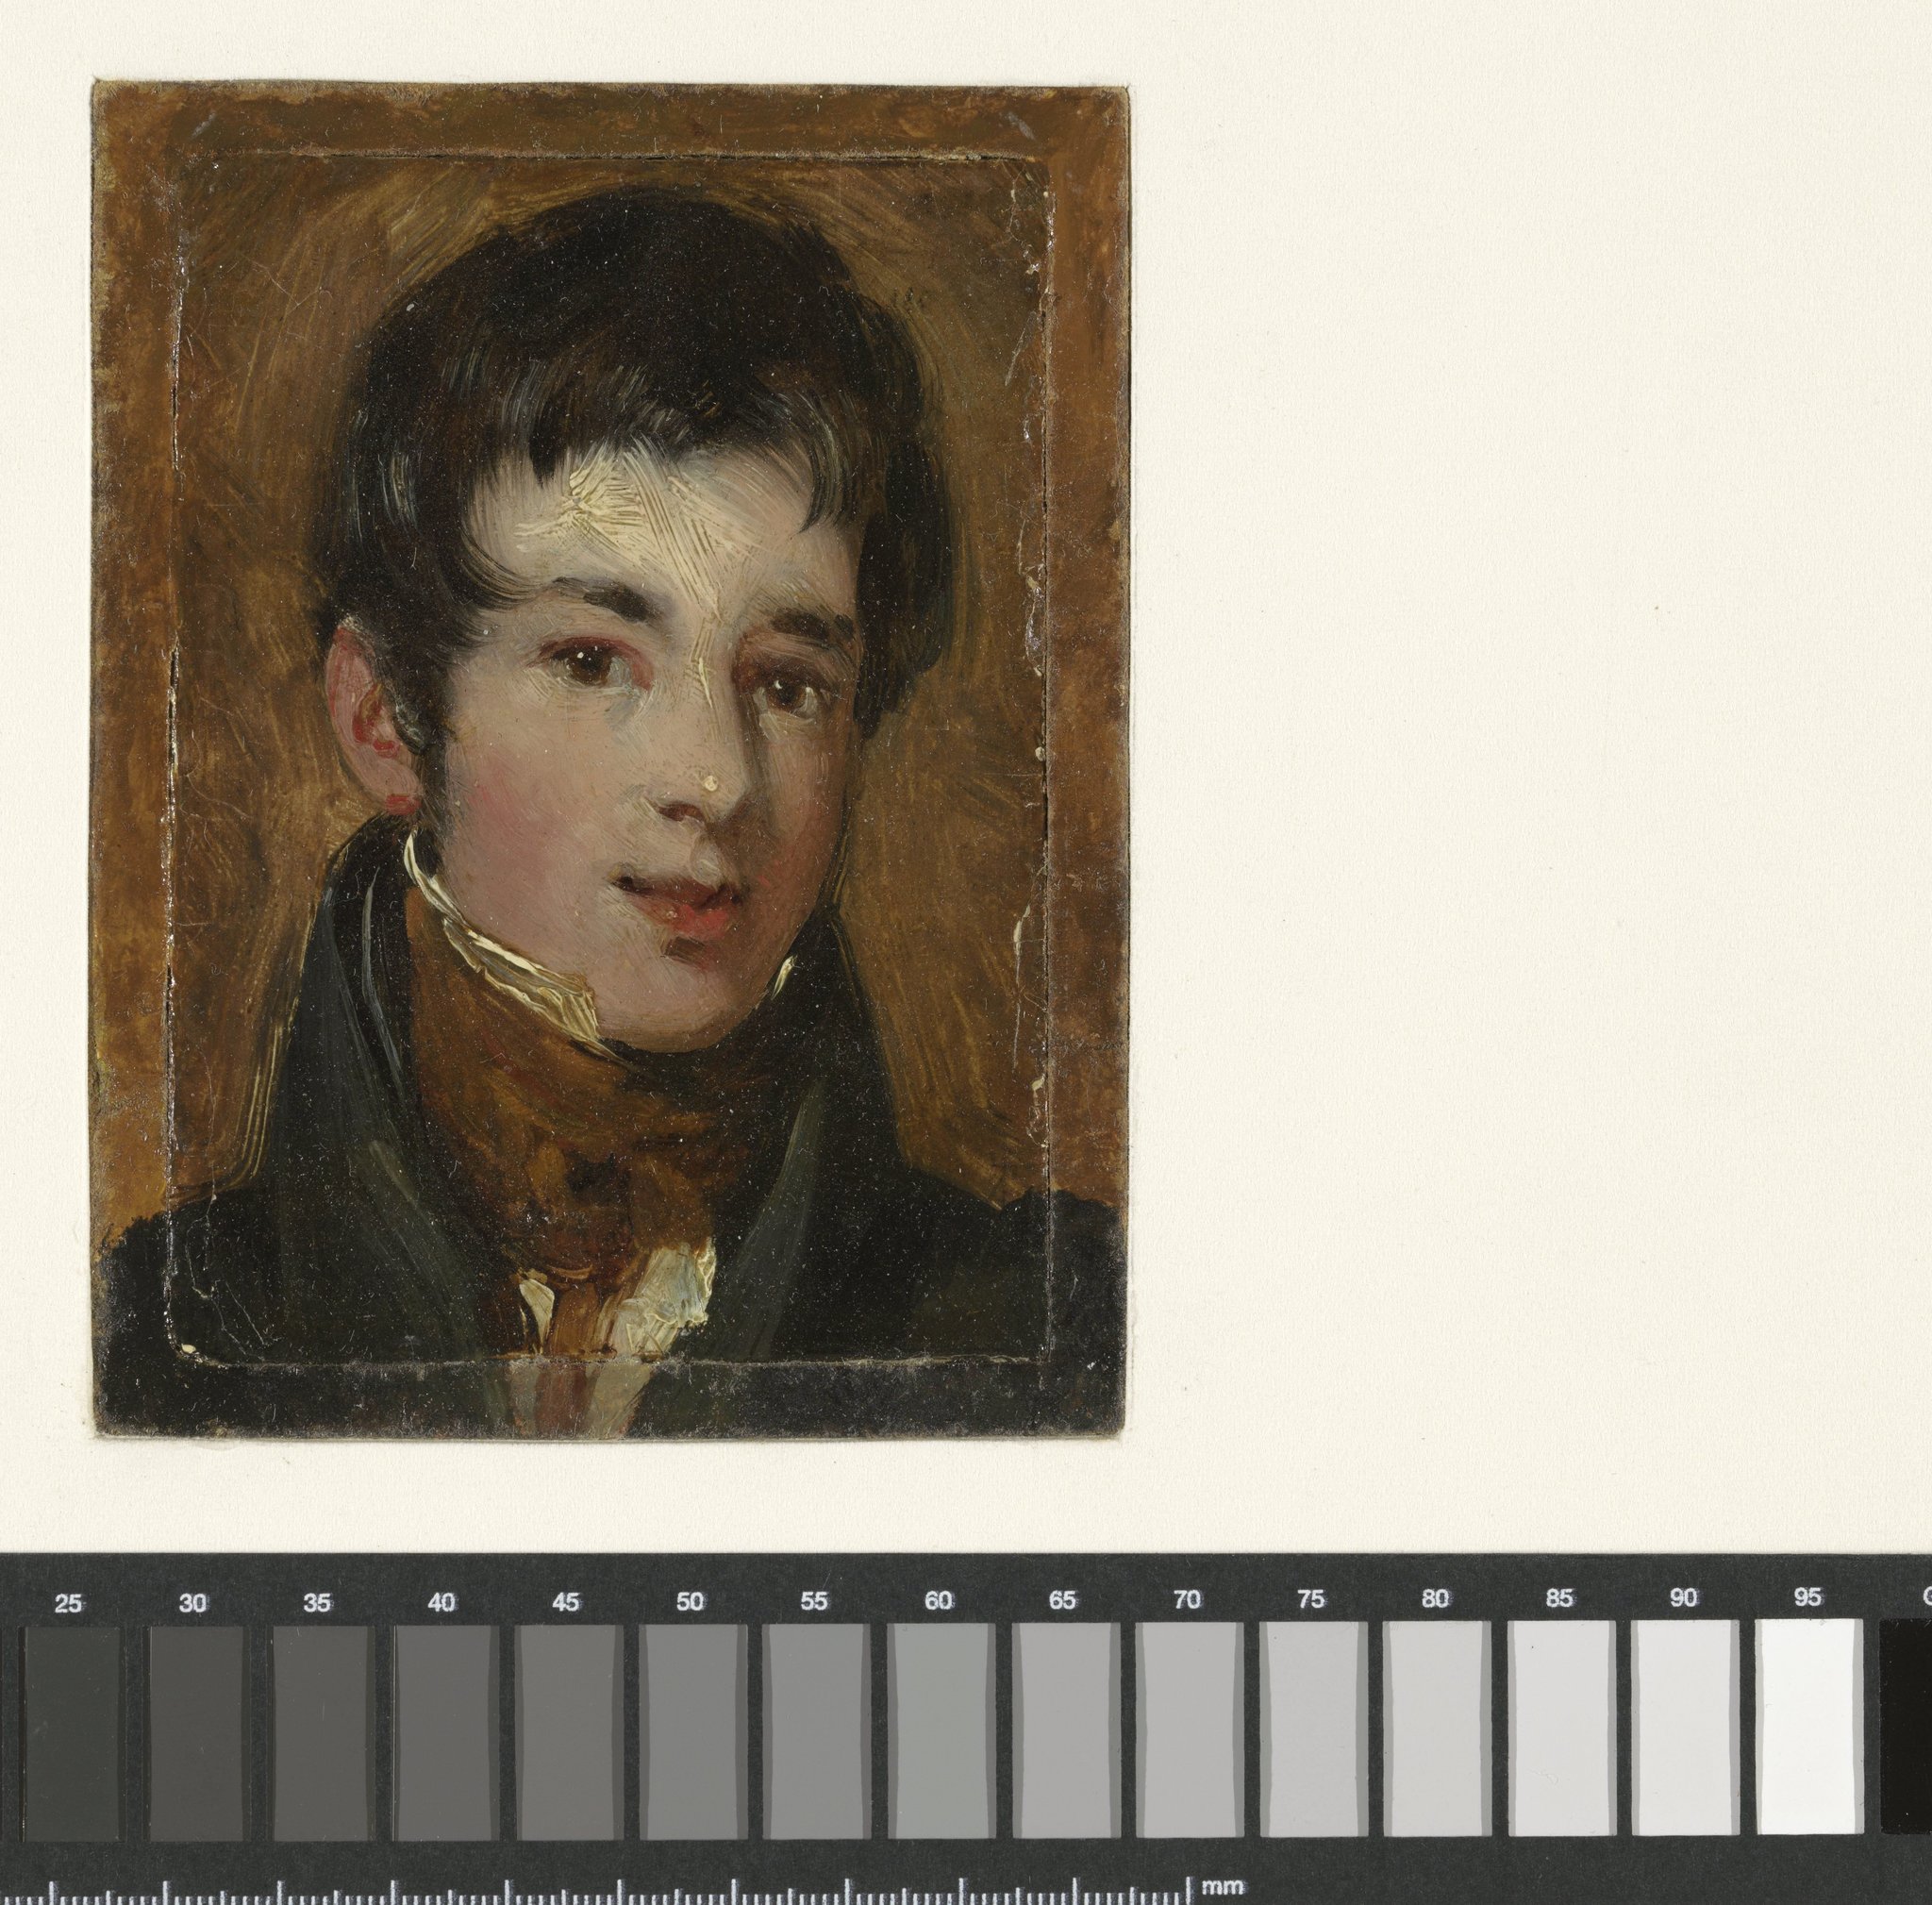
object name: drawing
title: Portret van de schilder James Holland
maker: william henry hunt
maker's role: draughtsman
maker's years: 1790-1864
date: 1800-1840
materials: cardboard, board, oil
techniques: brush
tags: london, print maker, draughtsman, james holland, historical persons, portrait, self-portrait of painter, portrait, self-portrait of artist